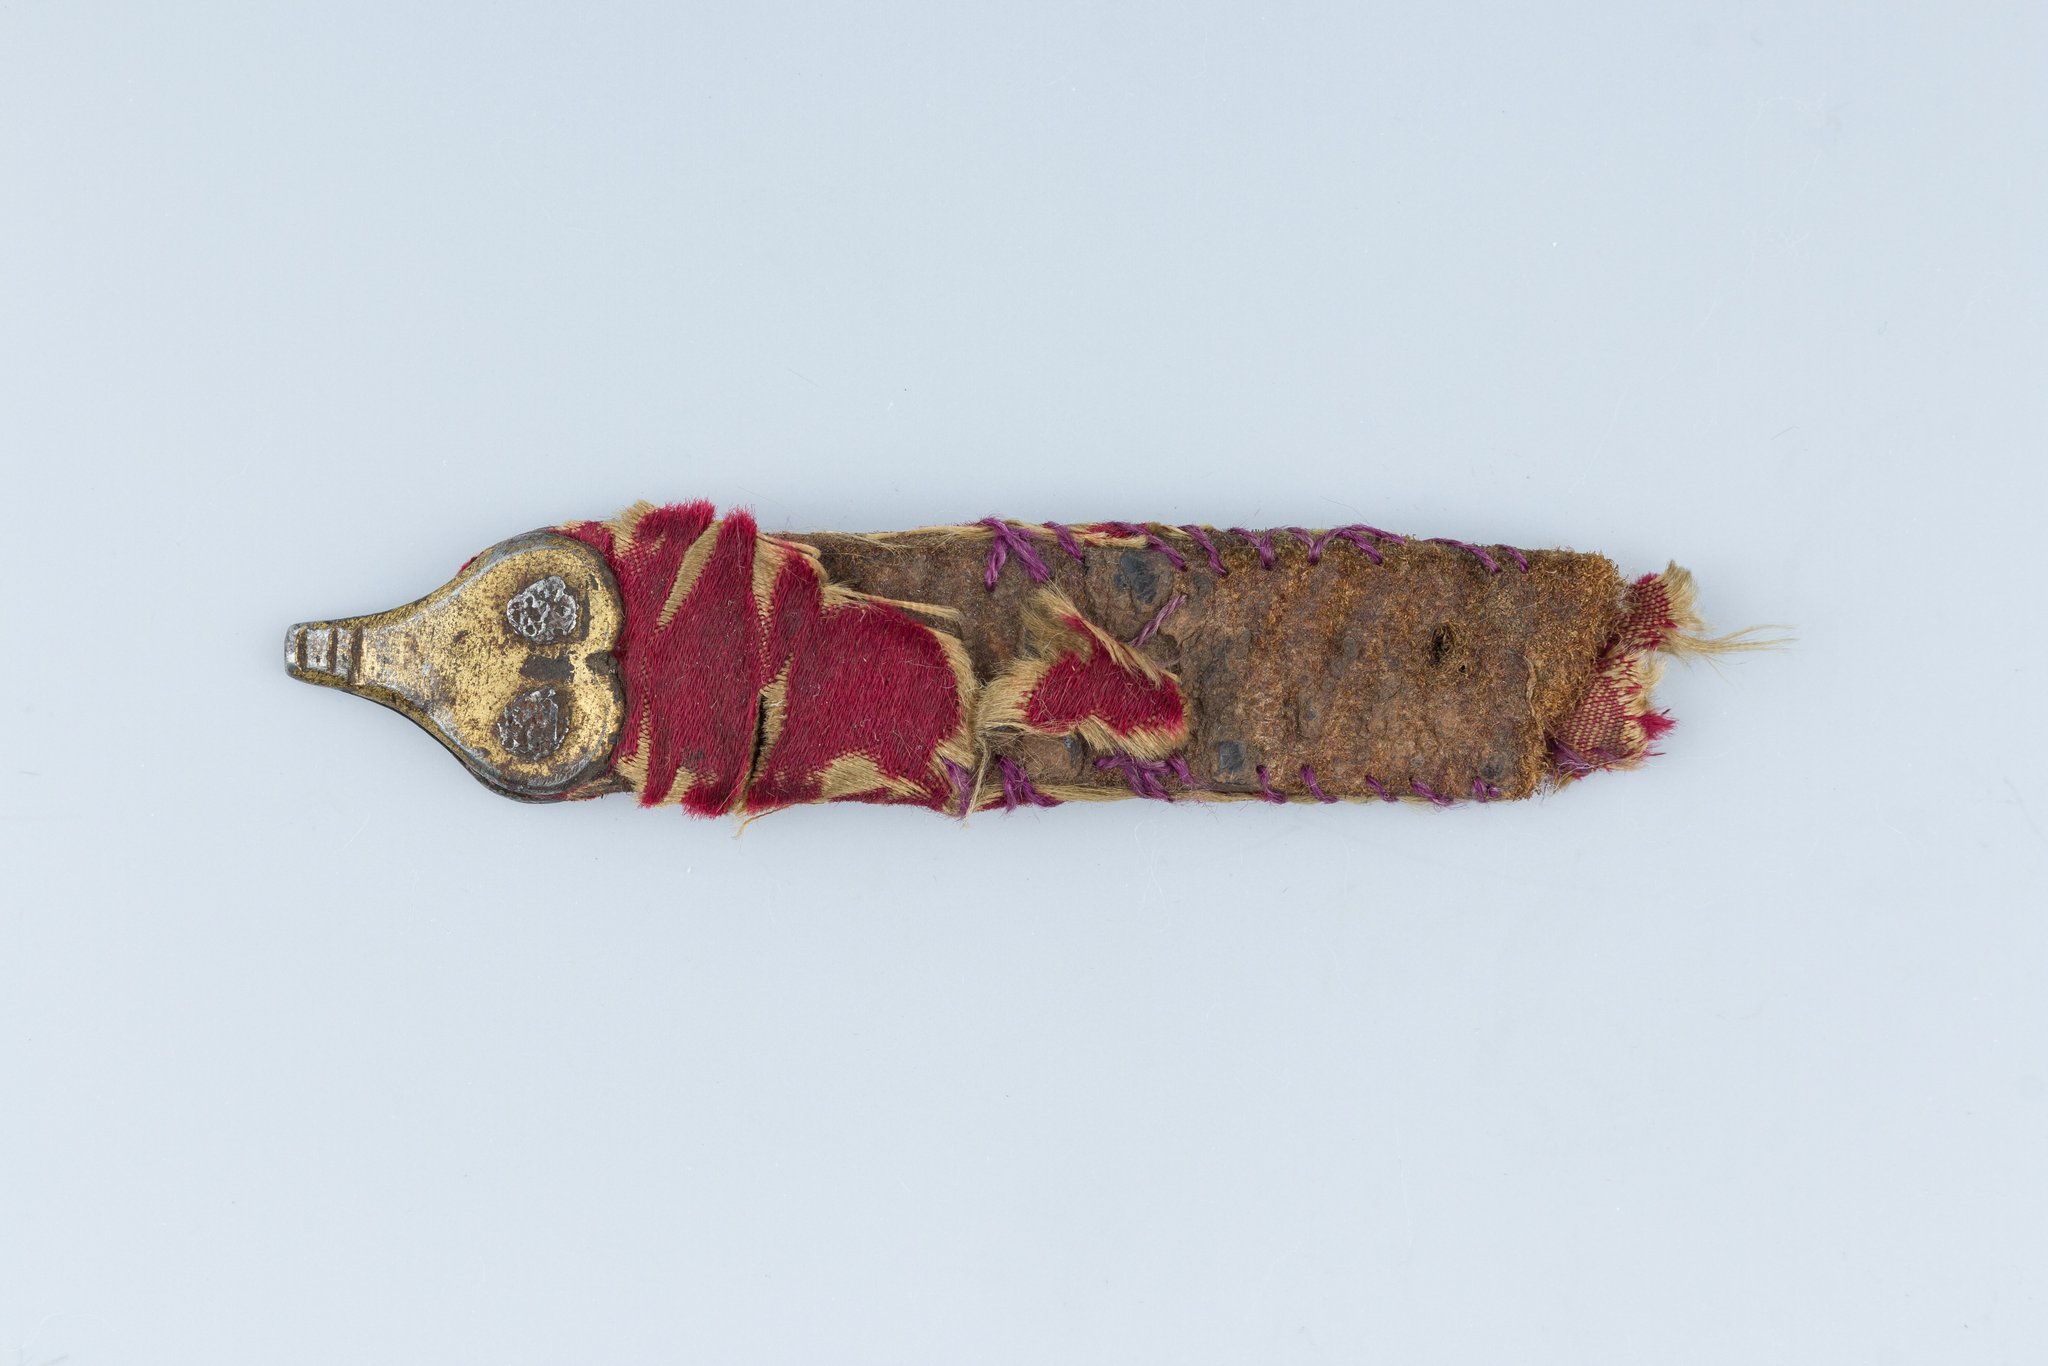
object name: mordant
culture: german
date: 1401-1600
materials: gilt, steel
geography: germany